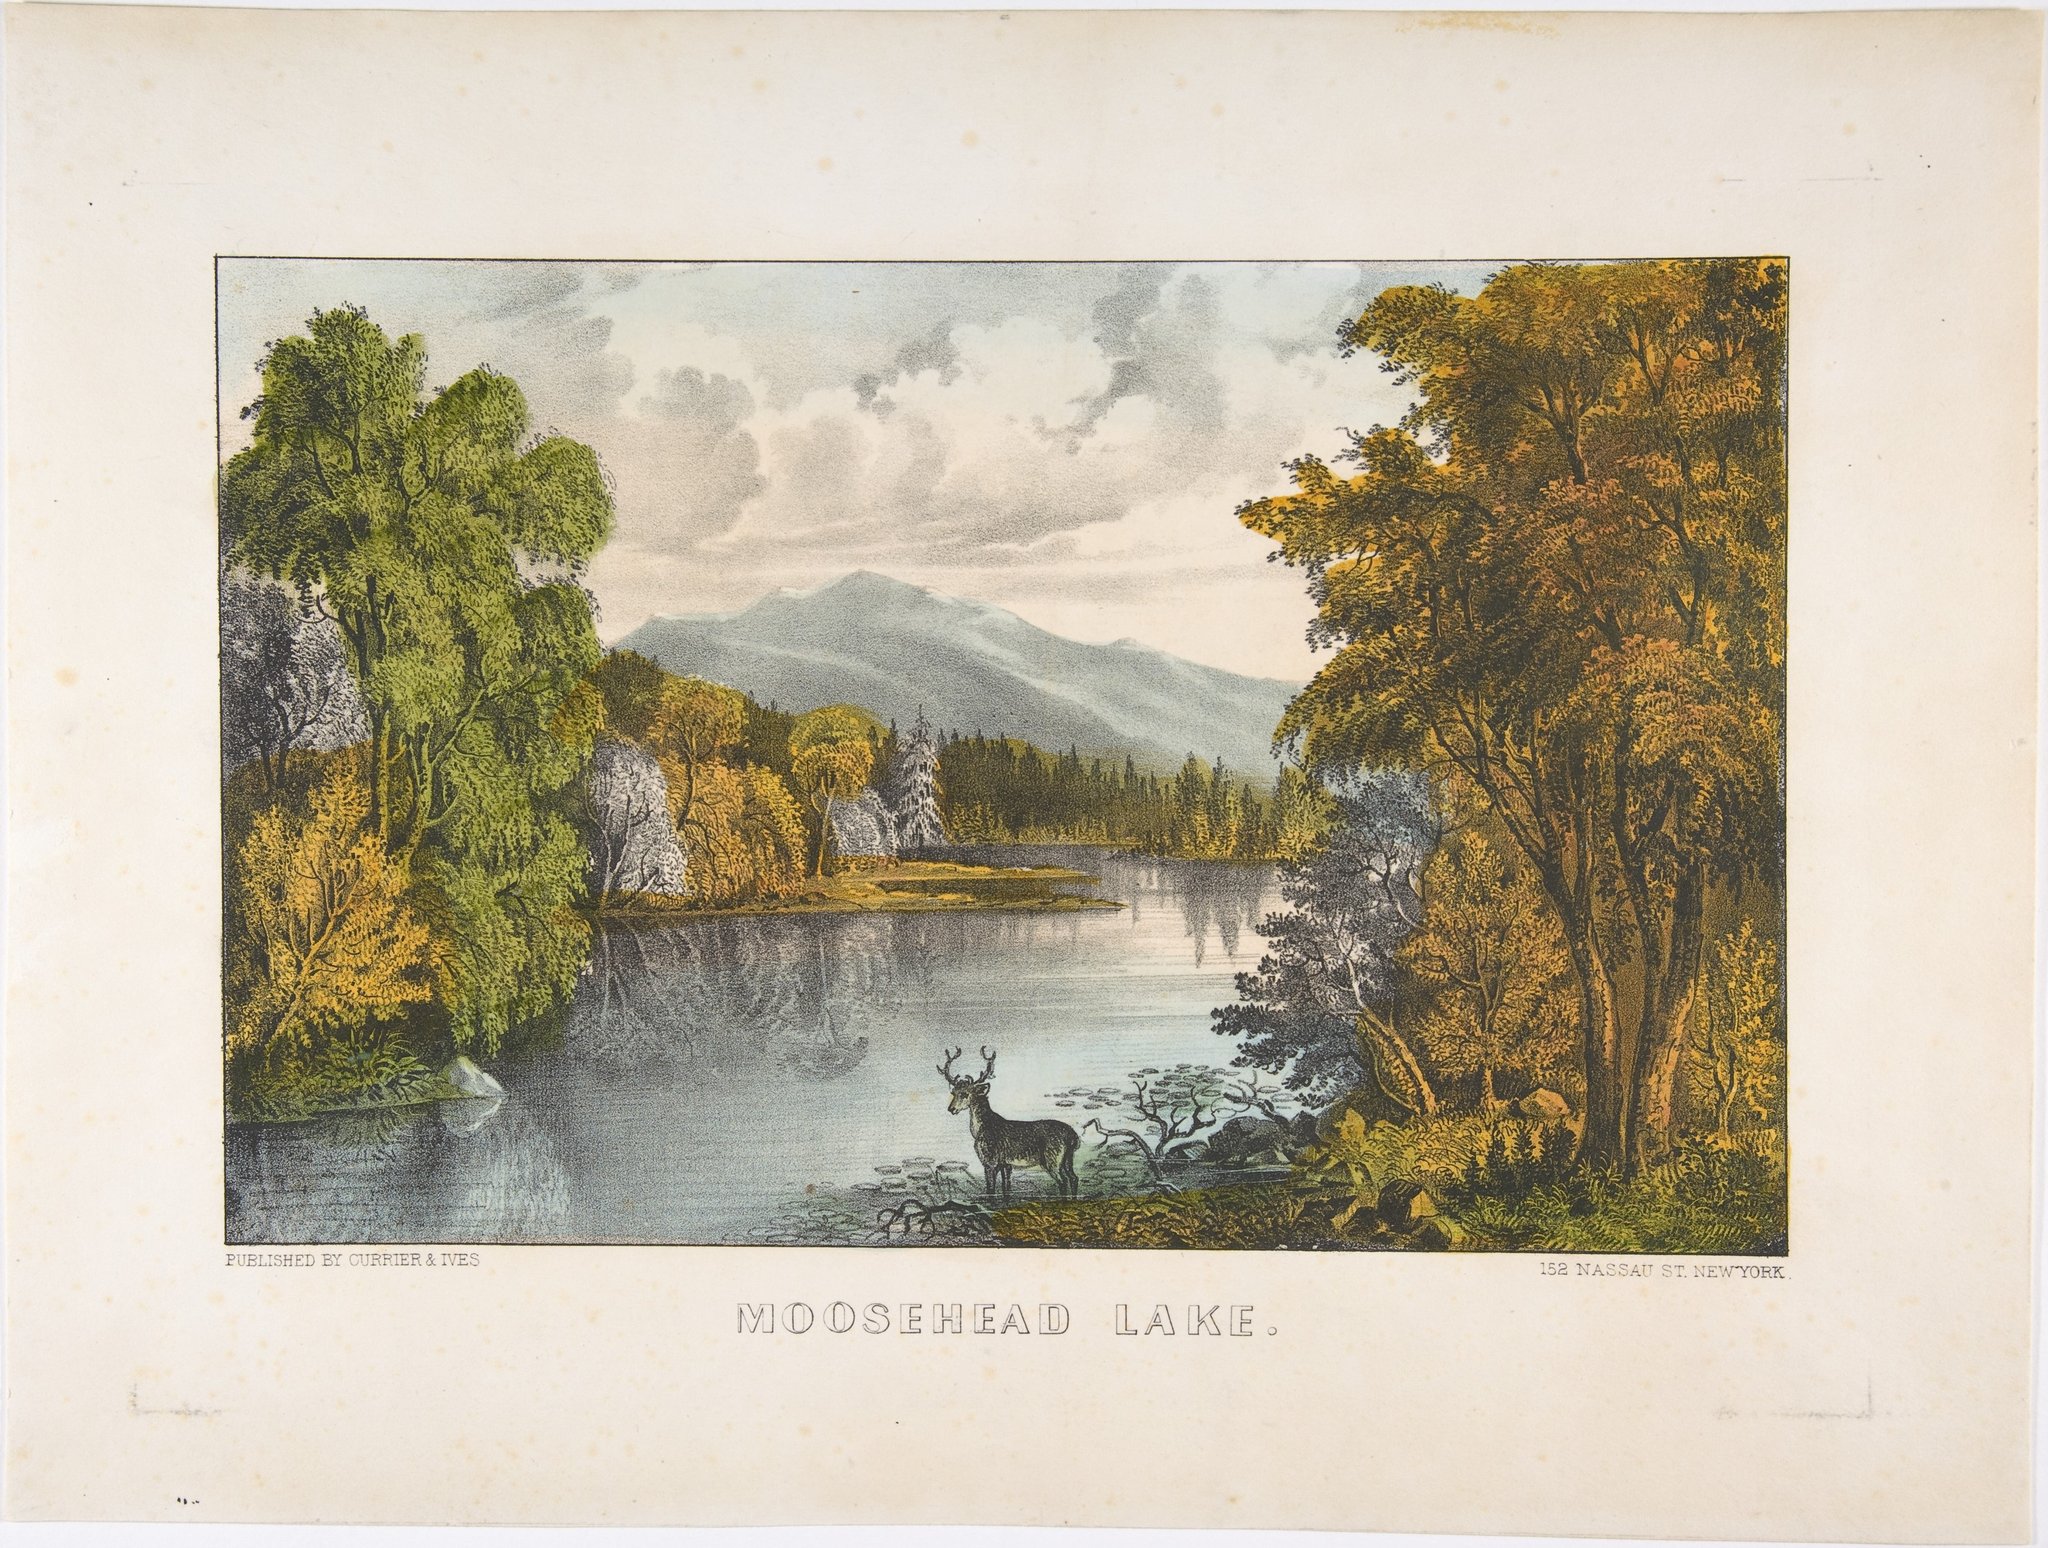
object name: print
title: Moosehead Lake, Maine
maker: currier & ives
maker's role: publisher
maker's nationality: american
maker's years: 1857-1907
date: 1857-1871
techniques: hand coloring, lithograph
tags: deer,lakes,mountains,trees